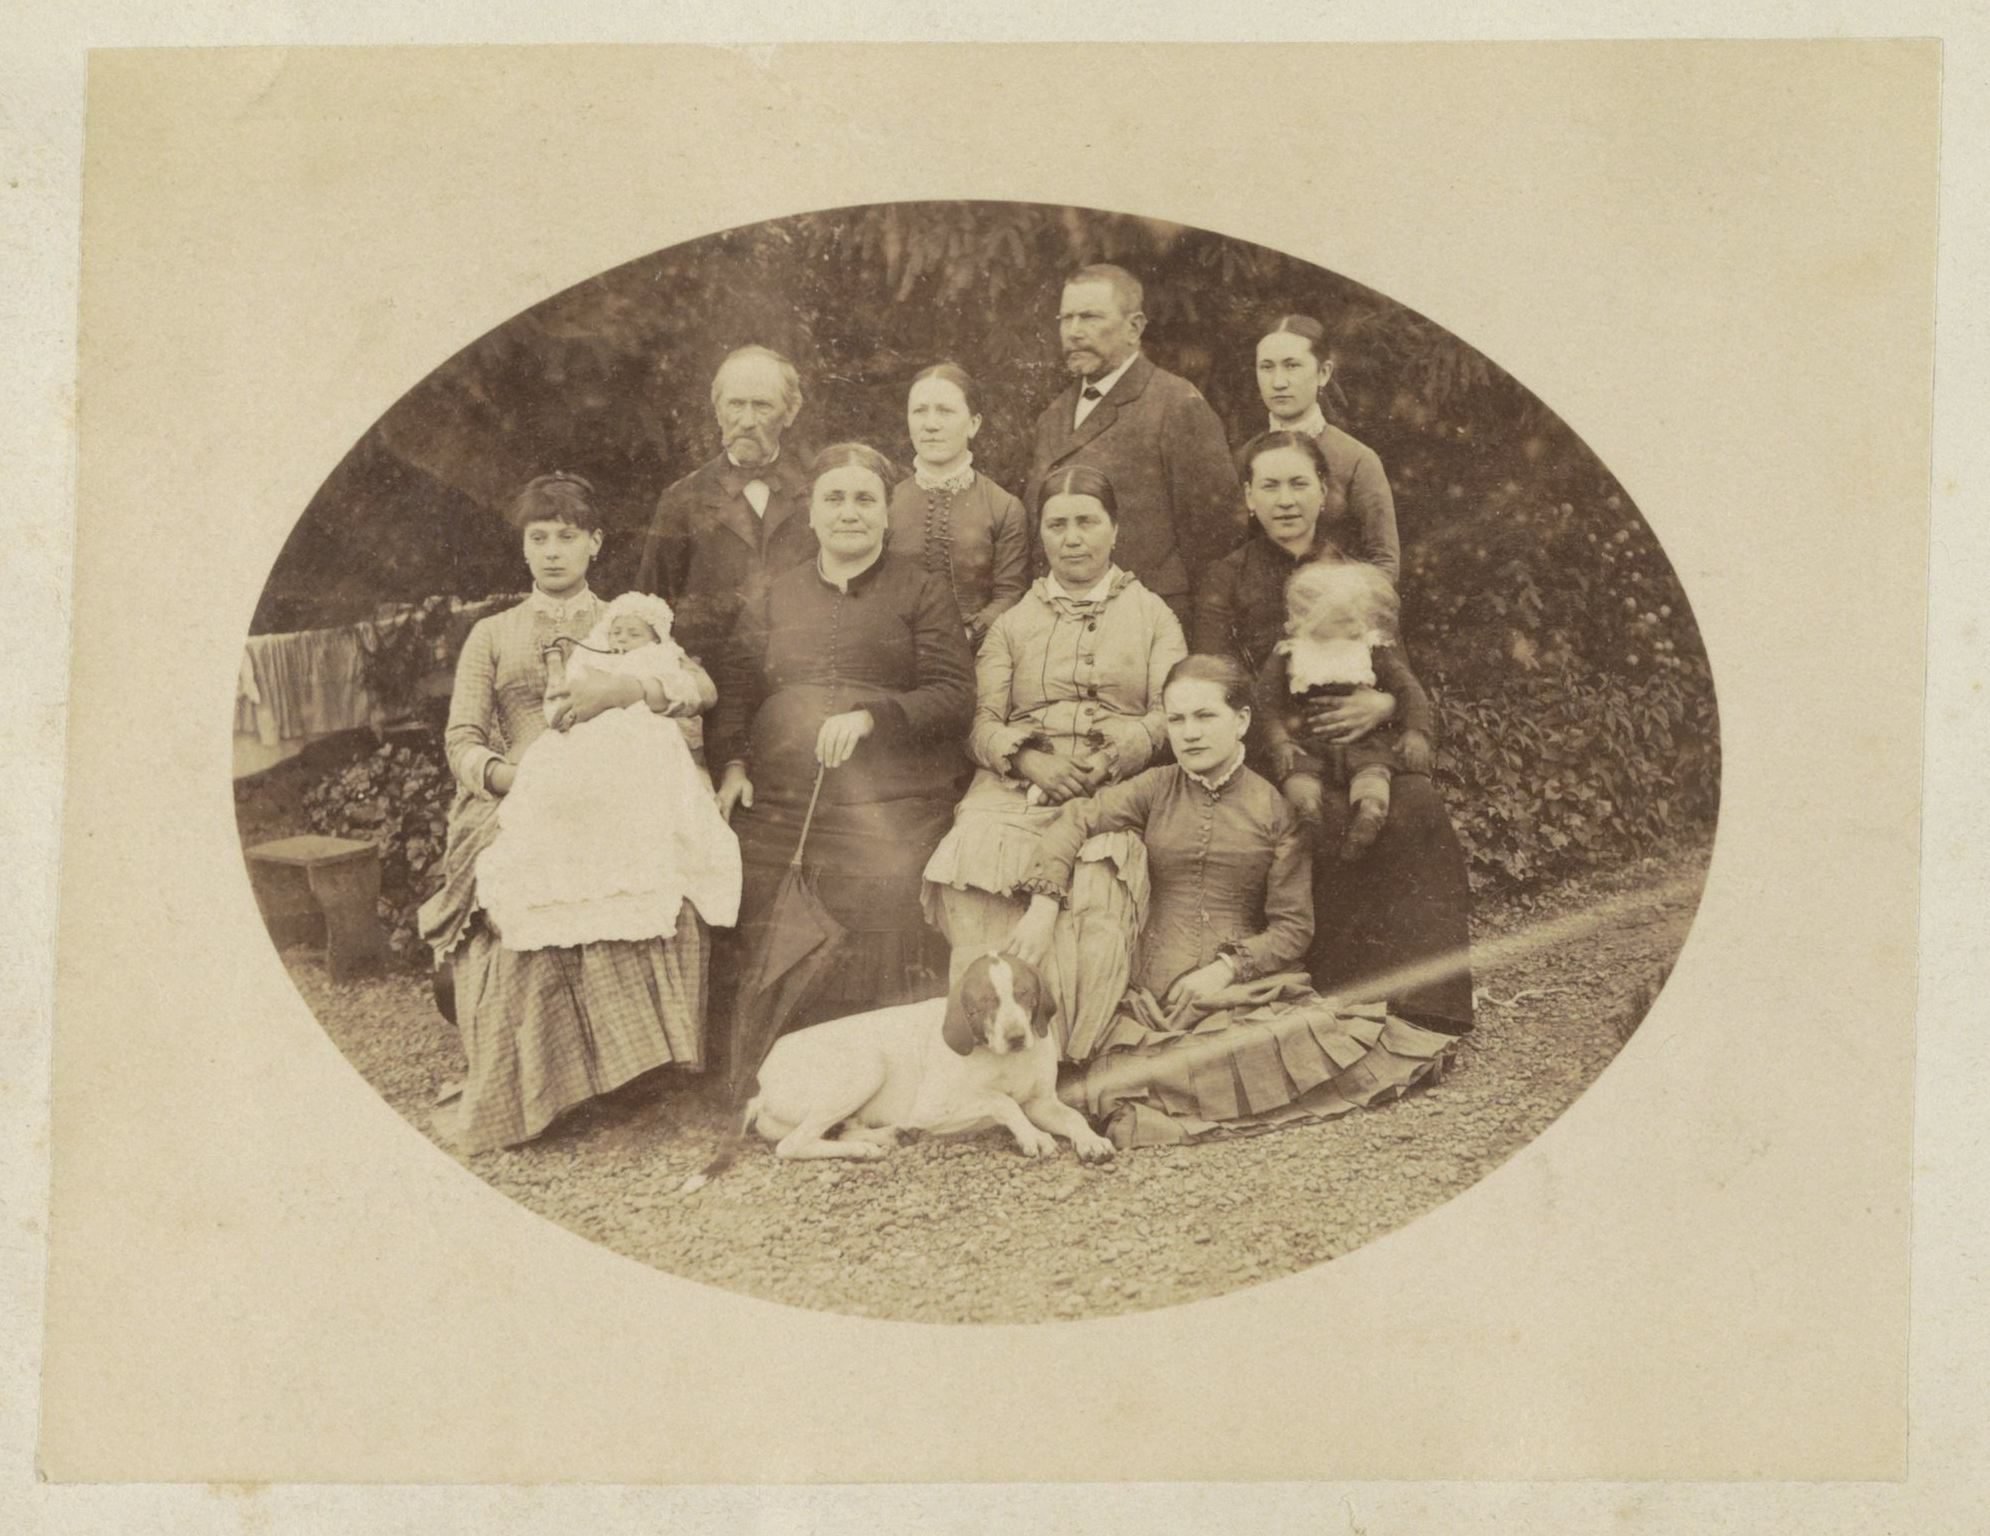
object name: photograph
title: Groepsportret van een Franse familie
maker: Anonymous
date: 1805-1884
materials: photographic support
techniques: albumen print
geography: france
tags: three generations (family group)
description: Onderdeel van Album van een Franse amateurfotograaf met opnames van familie, militairen, industrie, landschappen en bezienswaardigheden in Frankrijk.